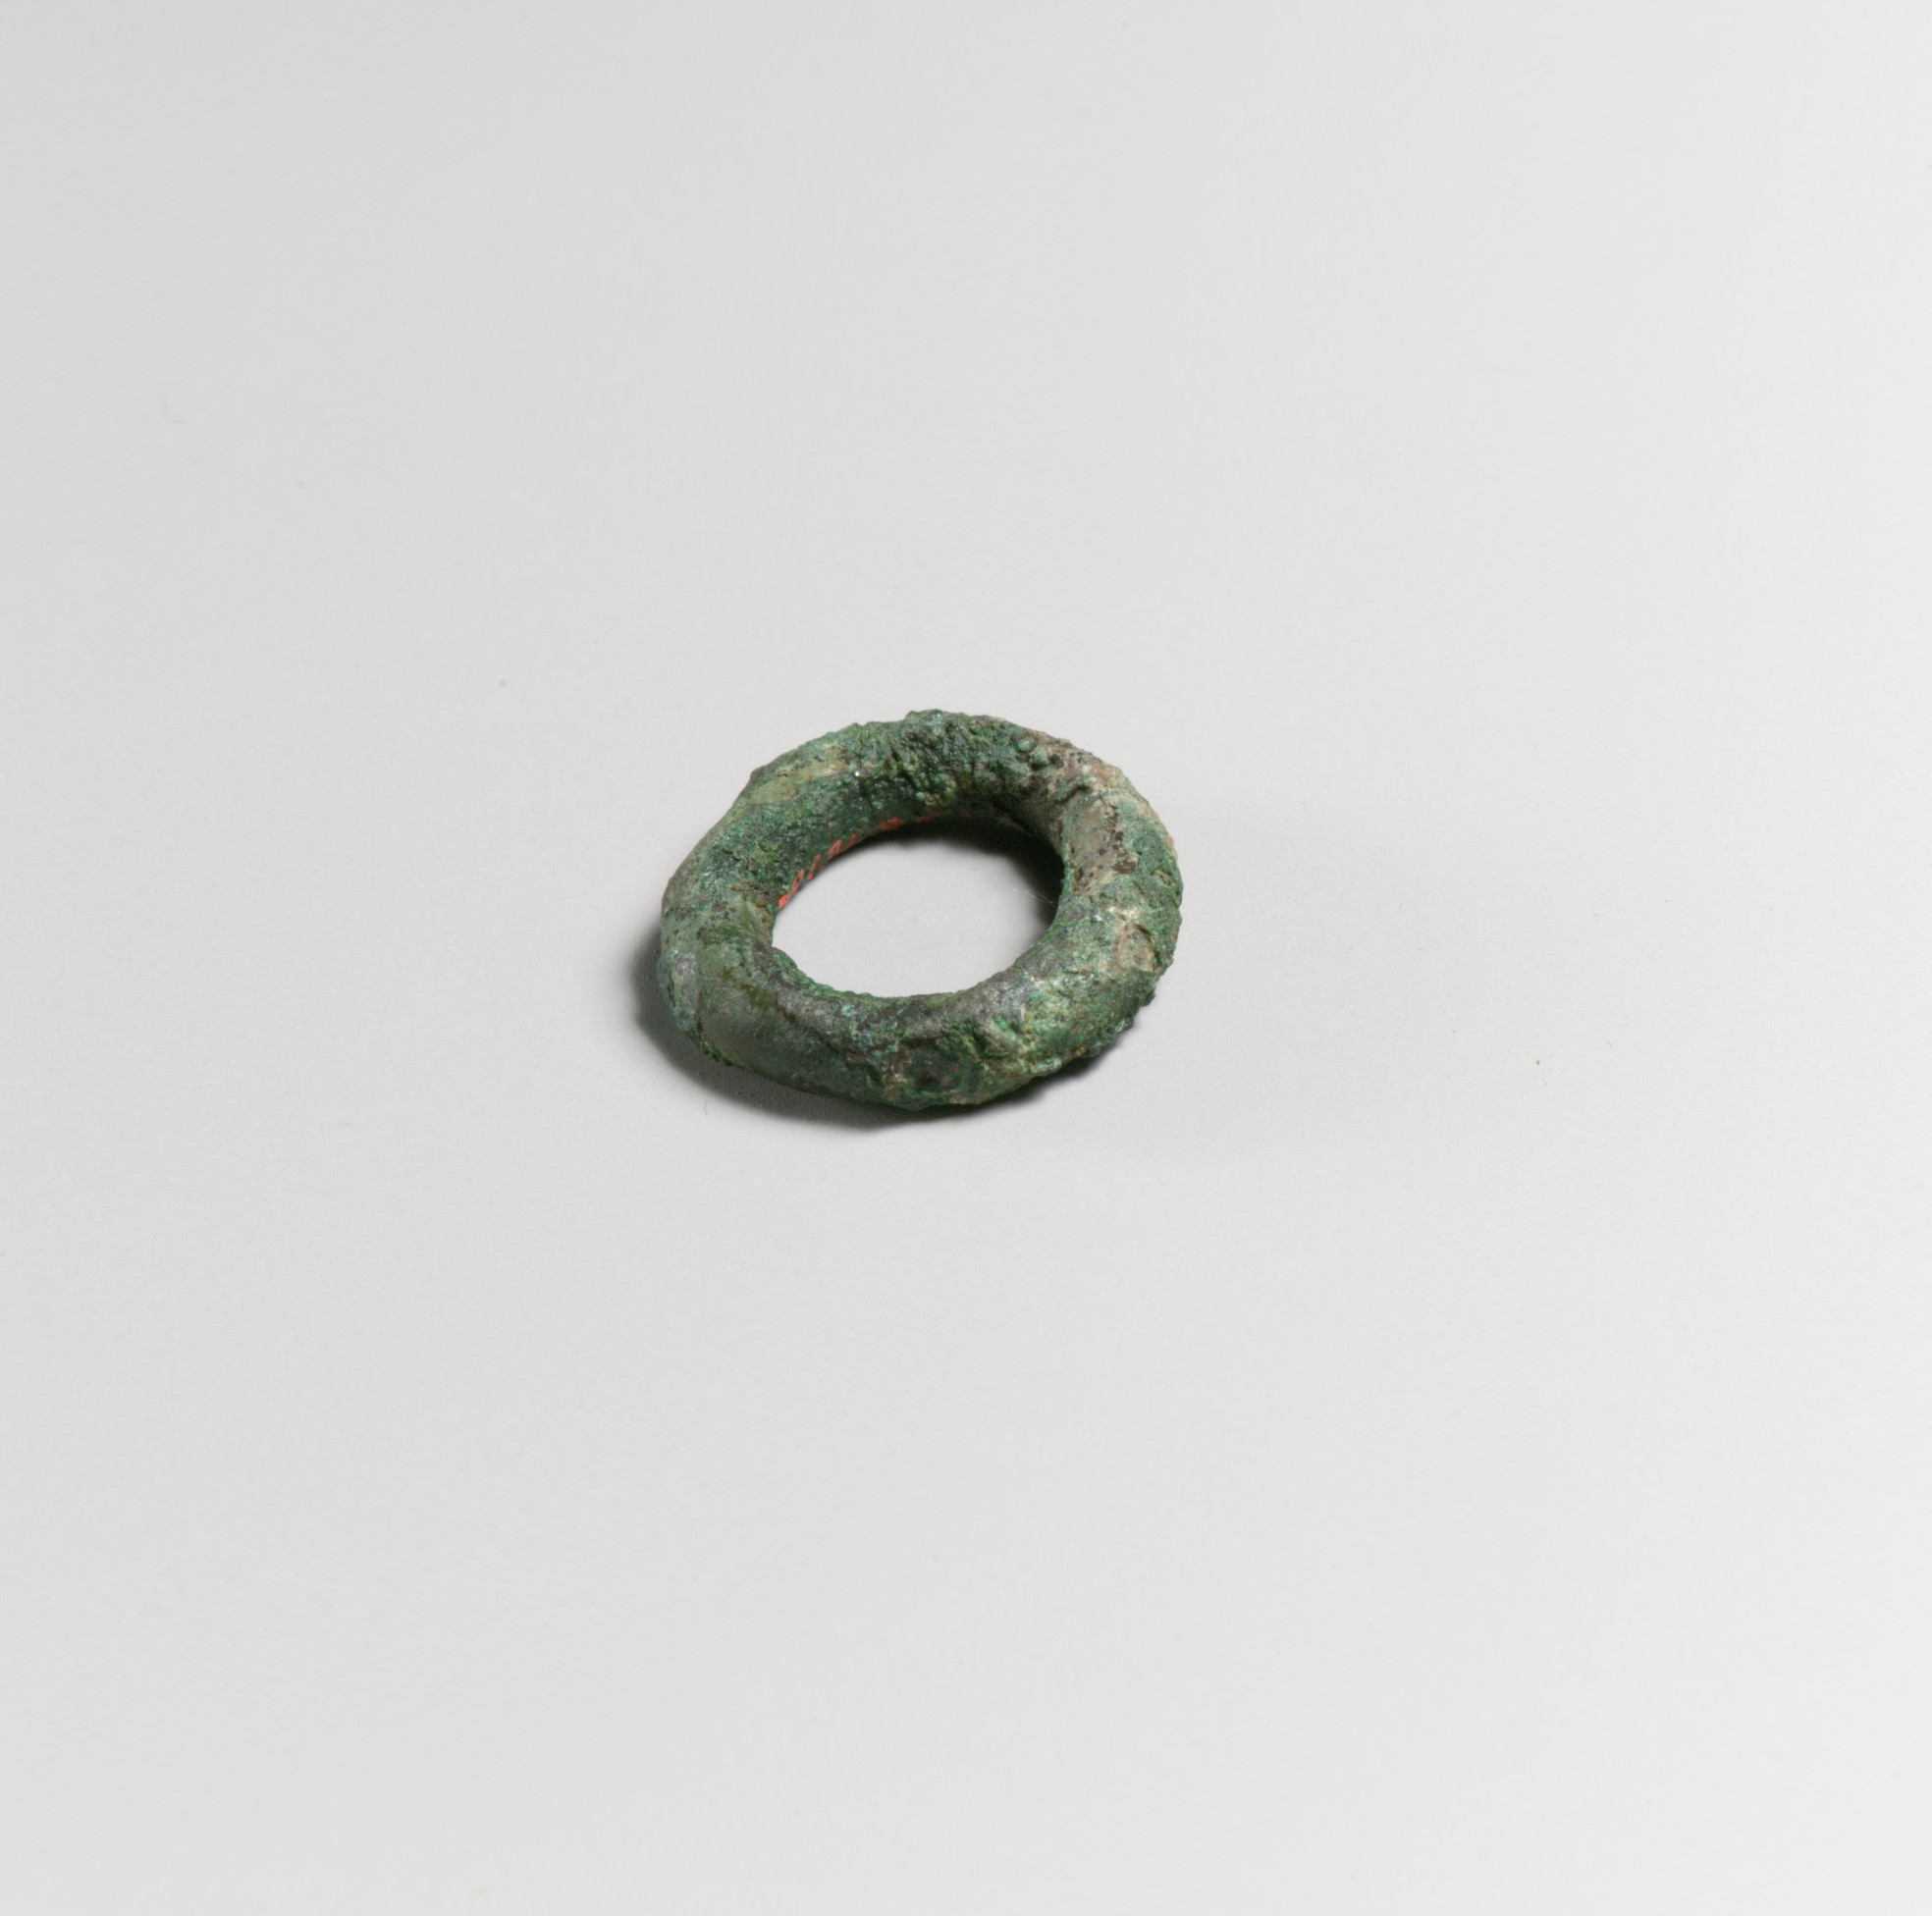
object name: chariot fragment, ring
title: Fragments of a cart or chariot, rings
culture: etruscan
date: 500-480 BCE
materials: bronze